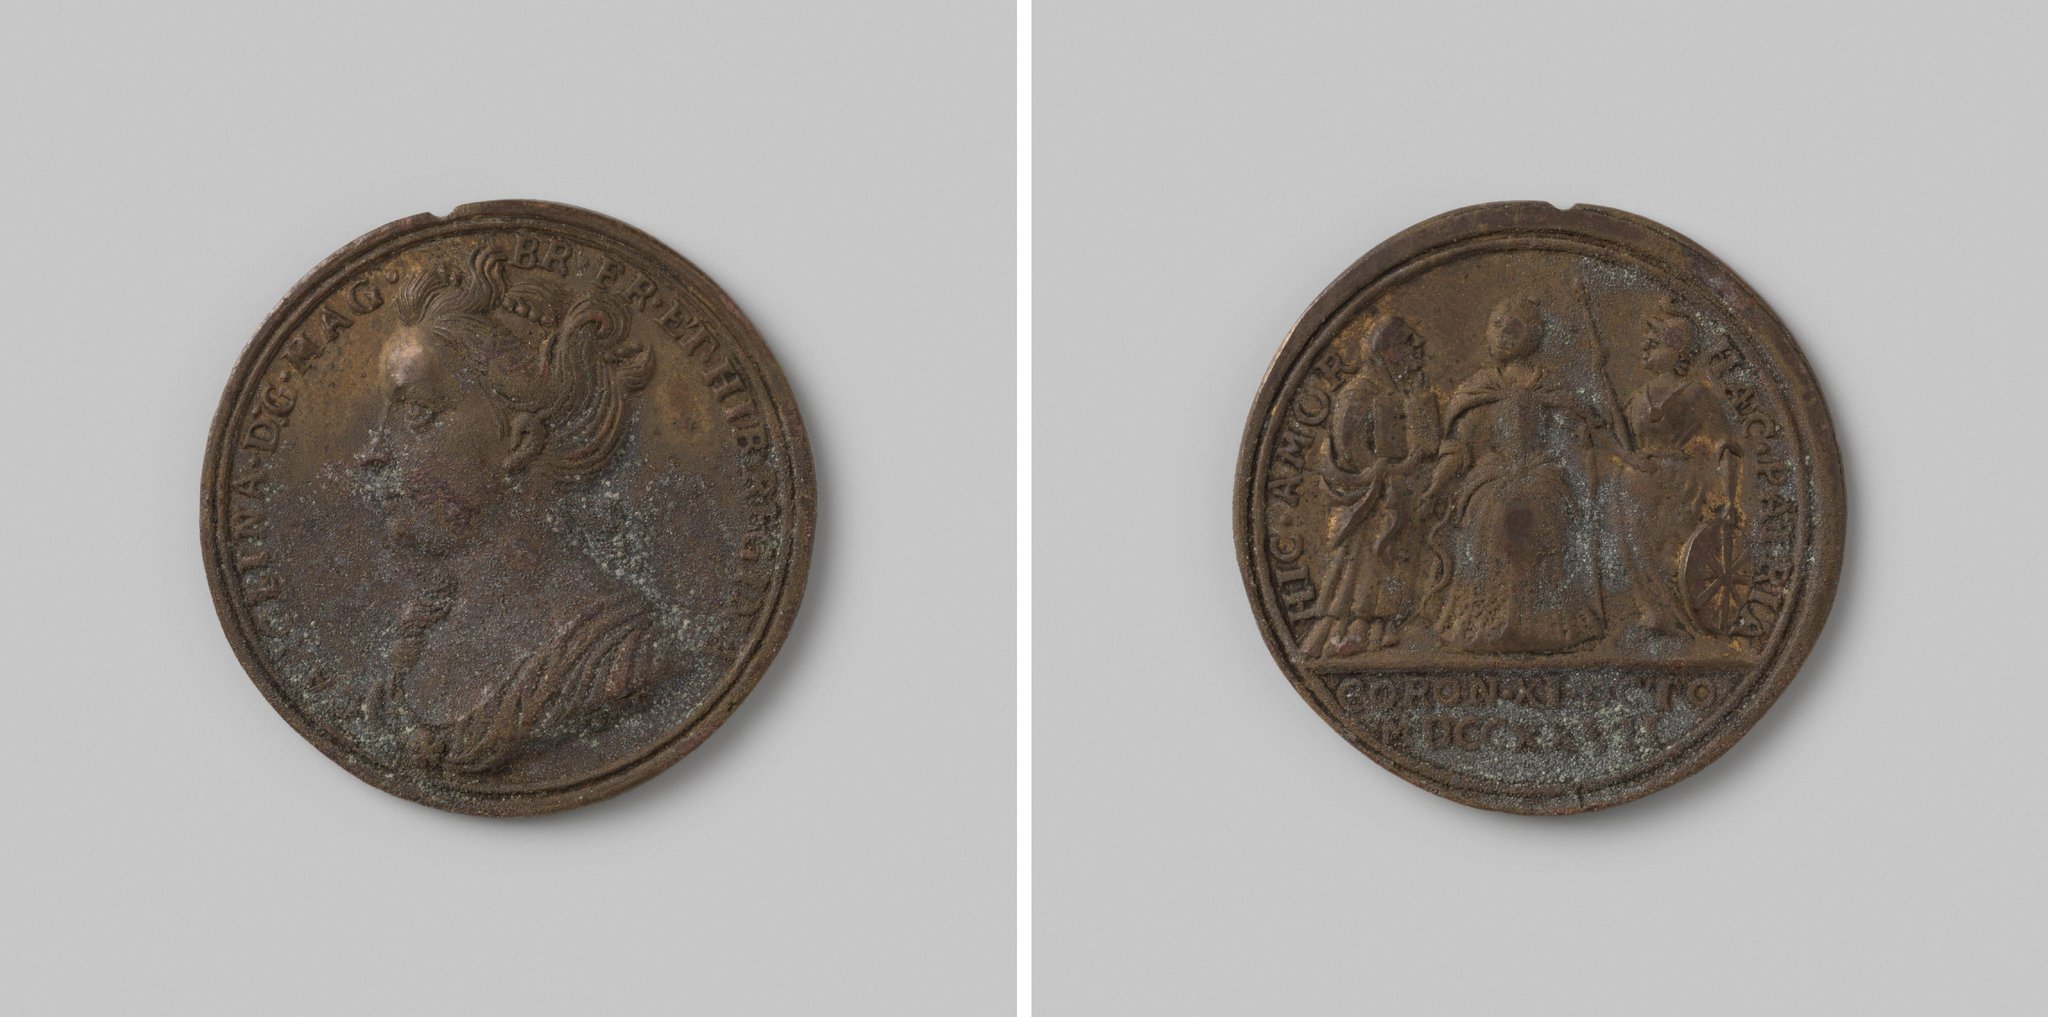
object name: history medal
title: Kroning van Koningin Carolina van Engeland 1727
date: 1727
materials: brass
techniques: striking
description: Messing penning, op de voorzijde het portret van Carolina, met omschrift, op de keerzijde Carolina getroond tussen gesluierde vrouw met bijbel en Brittannia, met omschrift en afsnedetekst